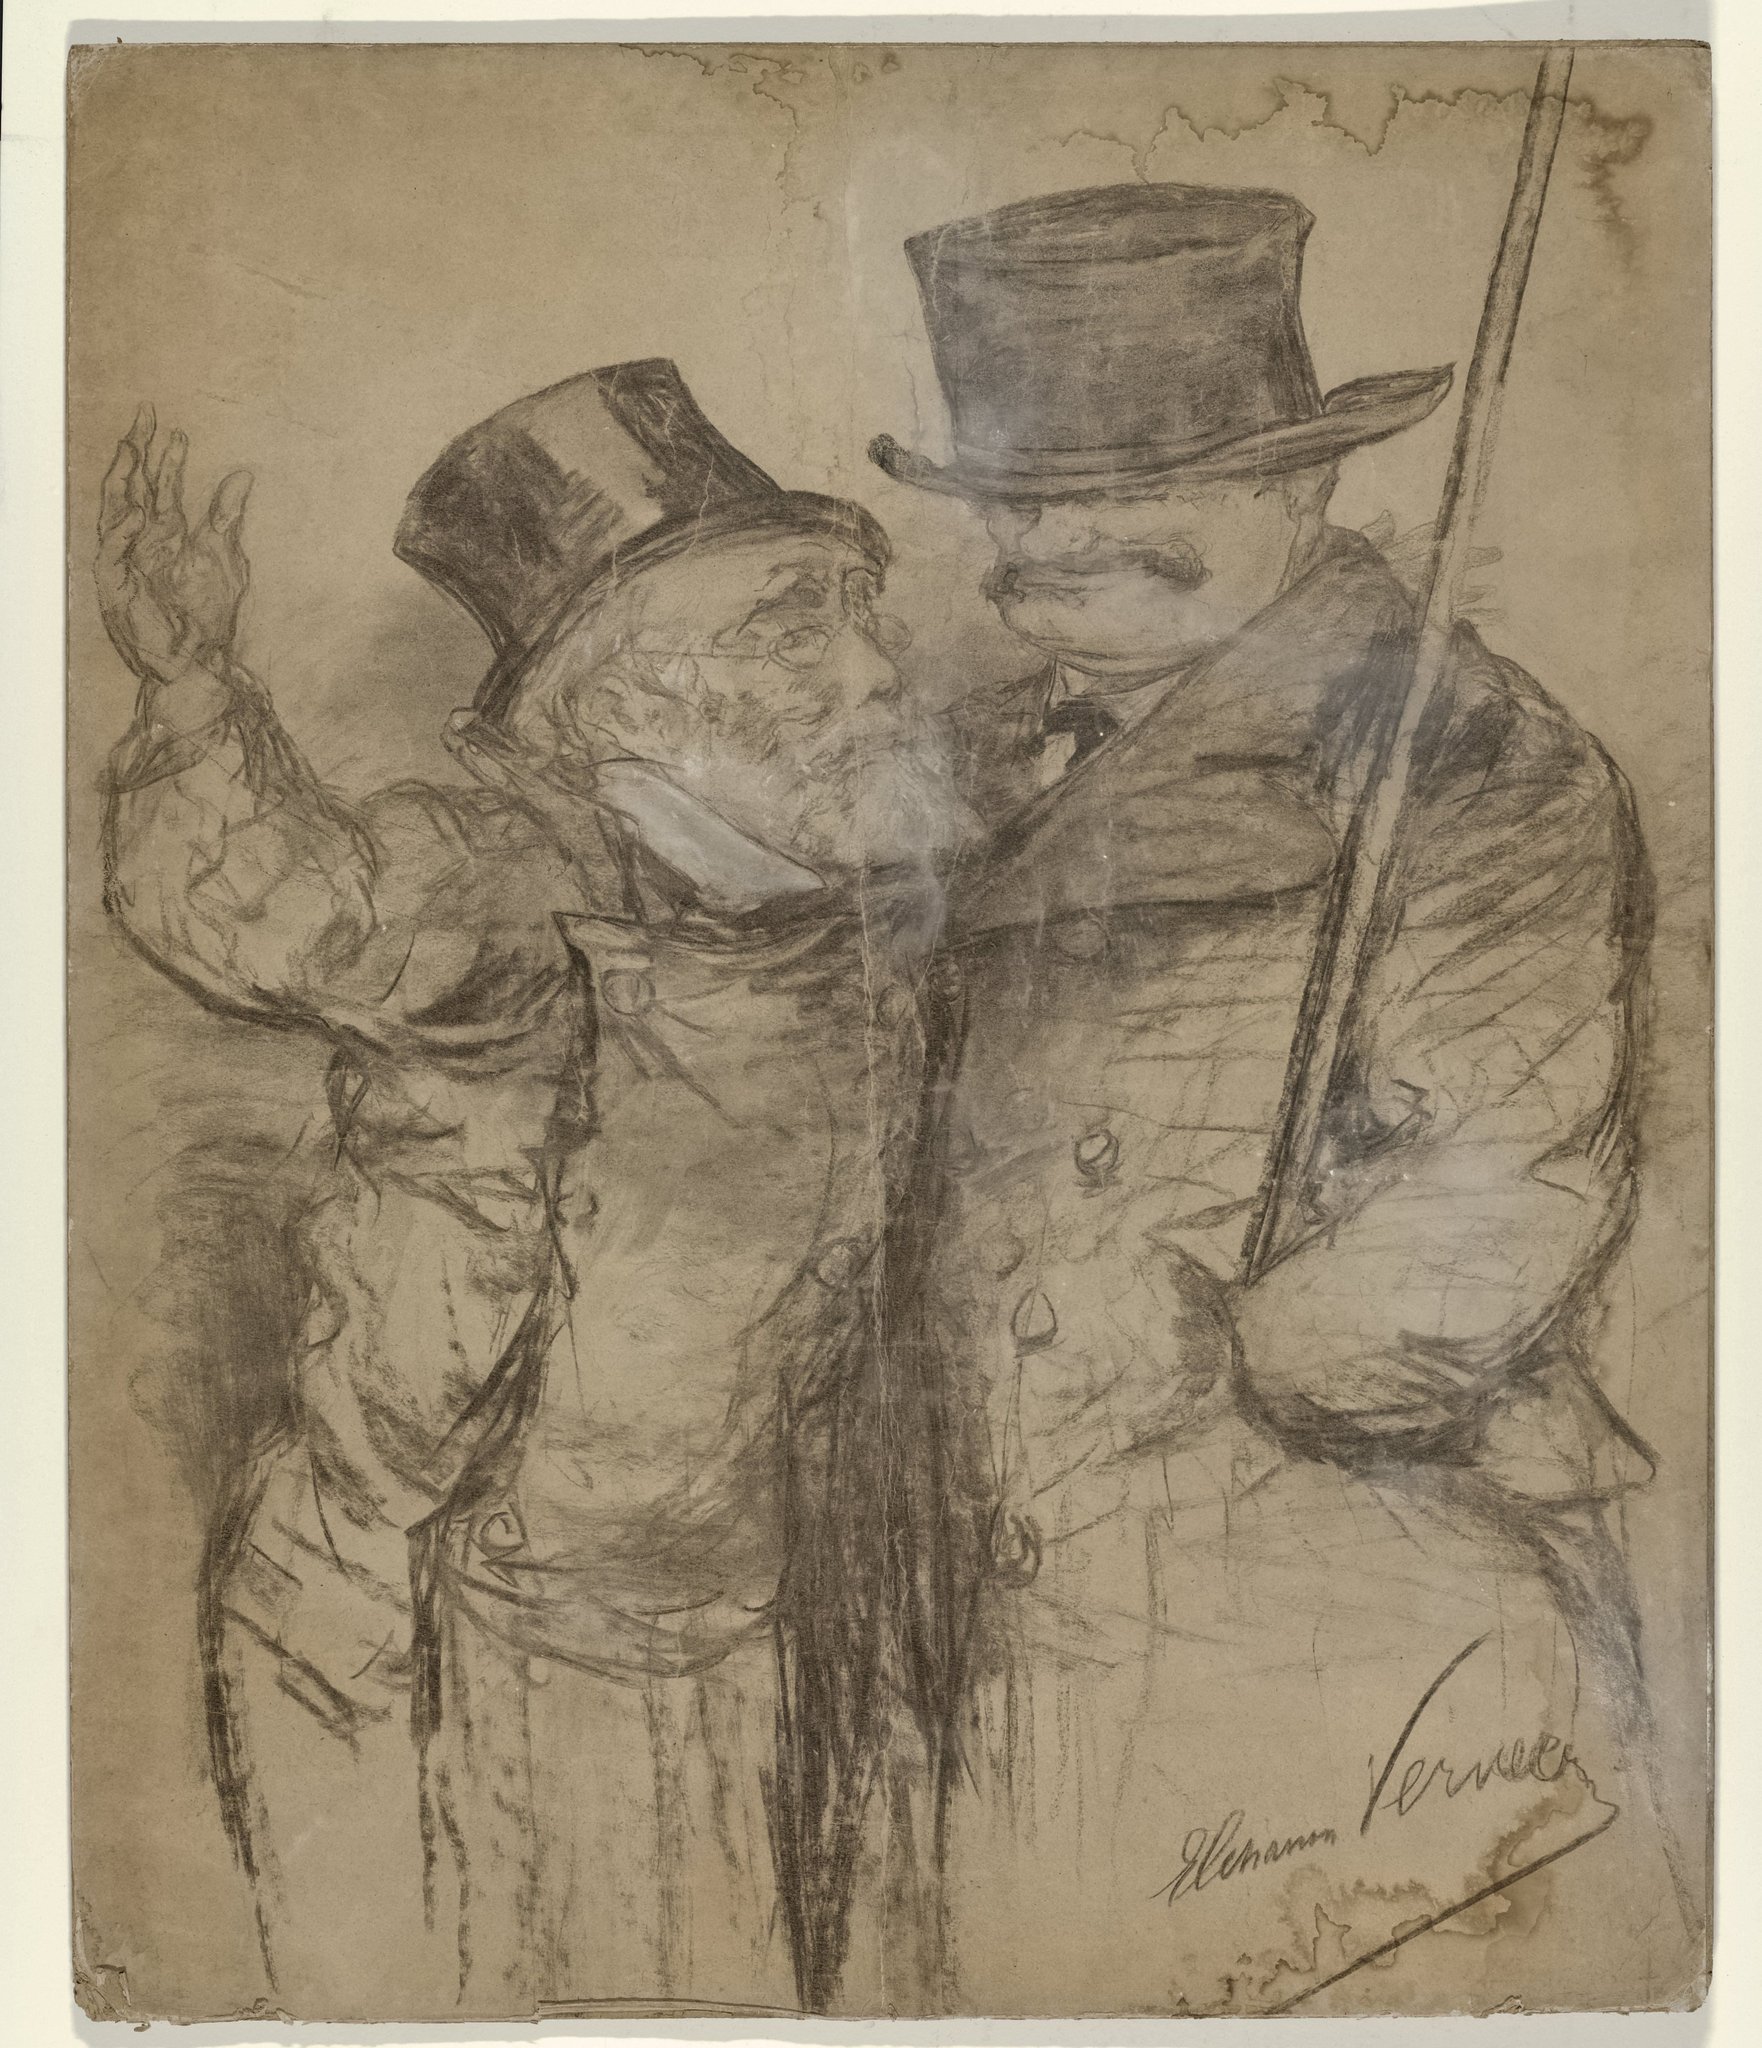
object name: caricature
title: Karikatuurportret van Jozef Israels en Salomon van Witsen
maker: elchanon verveer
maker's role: draughtsman, print maker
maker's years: 1826-1900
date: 1850-1899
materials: charcoal, paper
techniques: stumping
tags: the hague, painter, print maker, draughtsman, jozef israëls, salomon van witsen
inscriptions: signature: ‘Elchanon Verveer’, inscription: ‘identificatie van geportretteerde achterop karton’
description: Karikatuurportret van de kunstschilders Jozef Israels (1824-1911) en Salomon van Witsen (1833-1911).